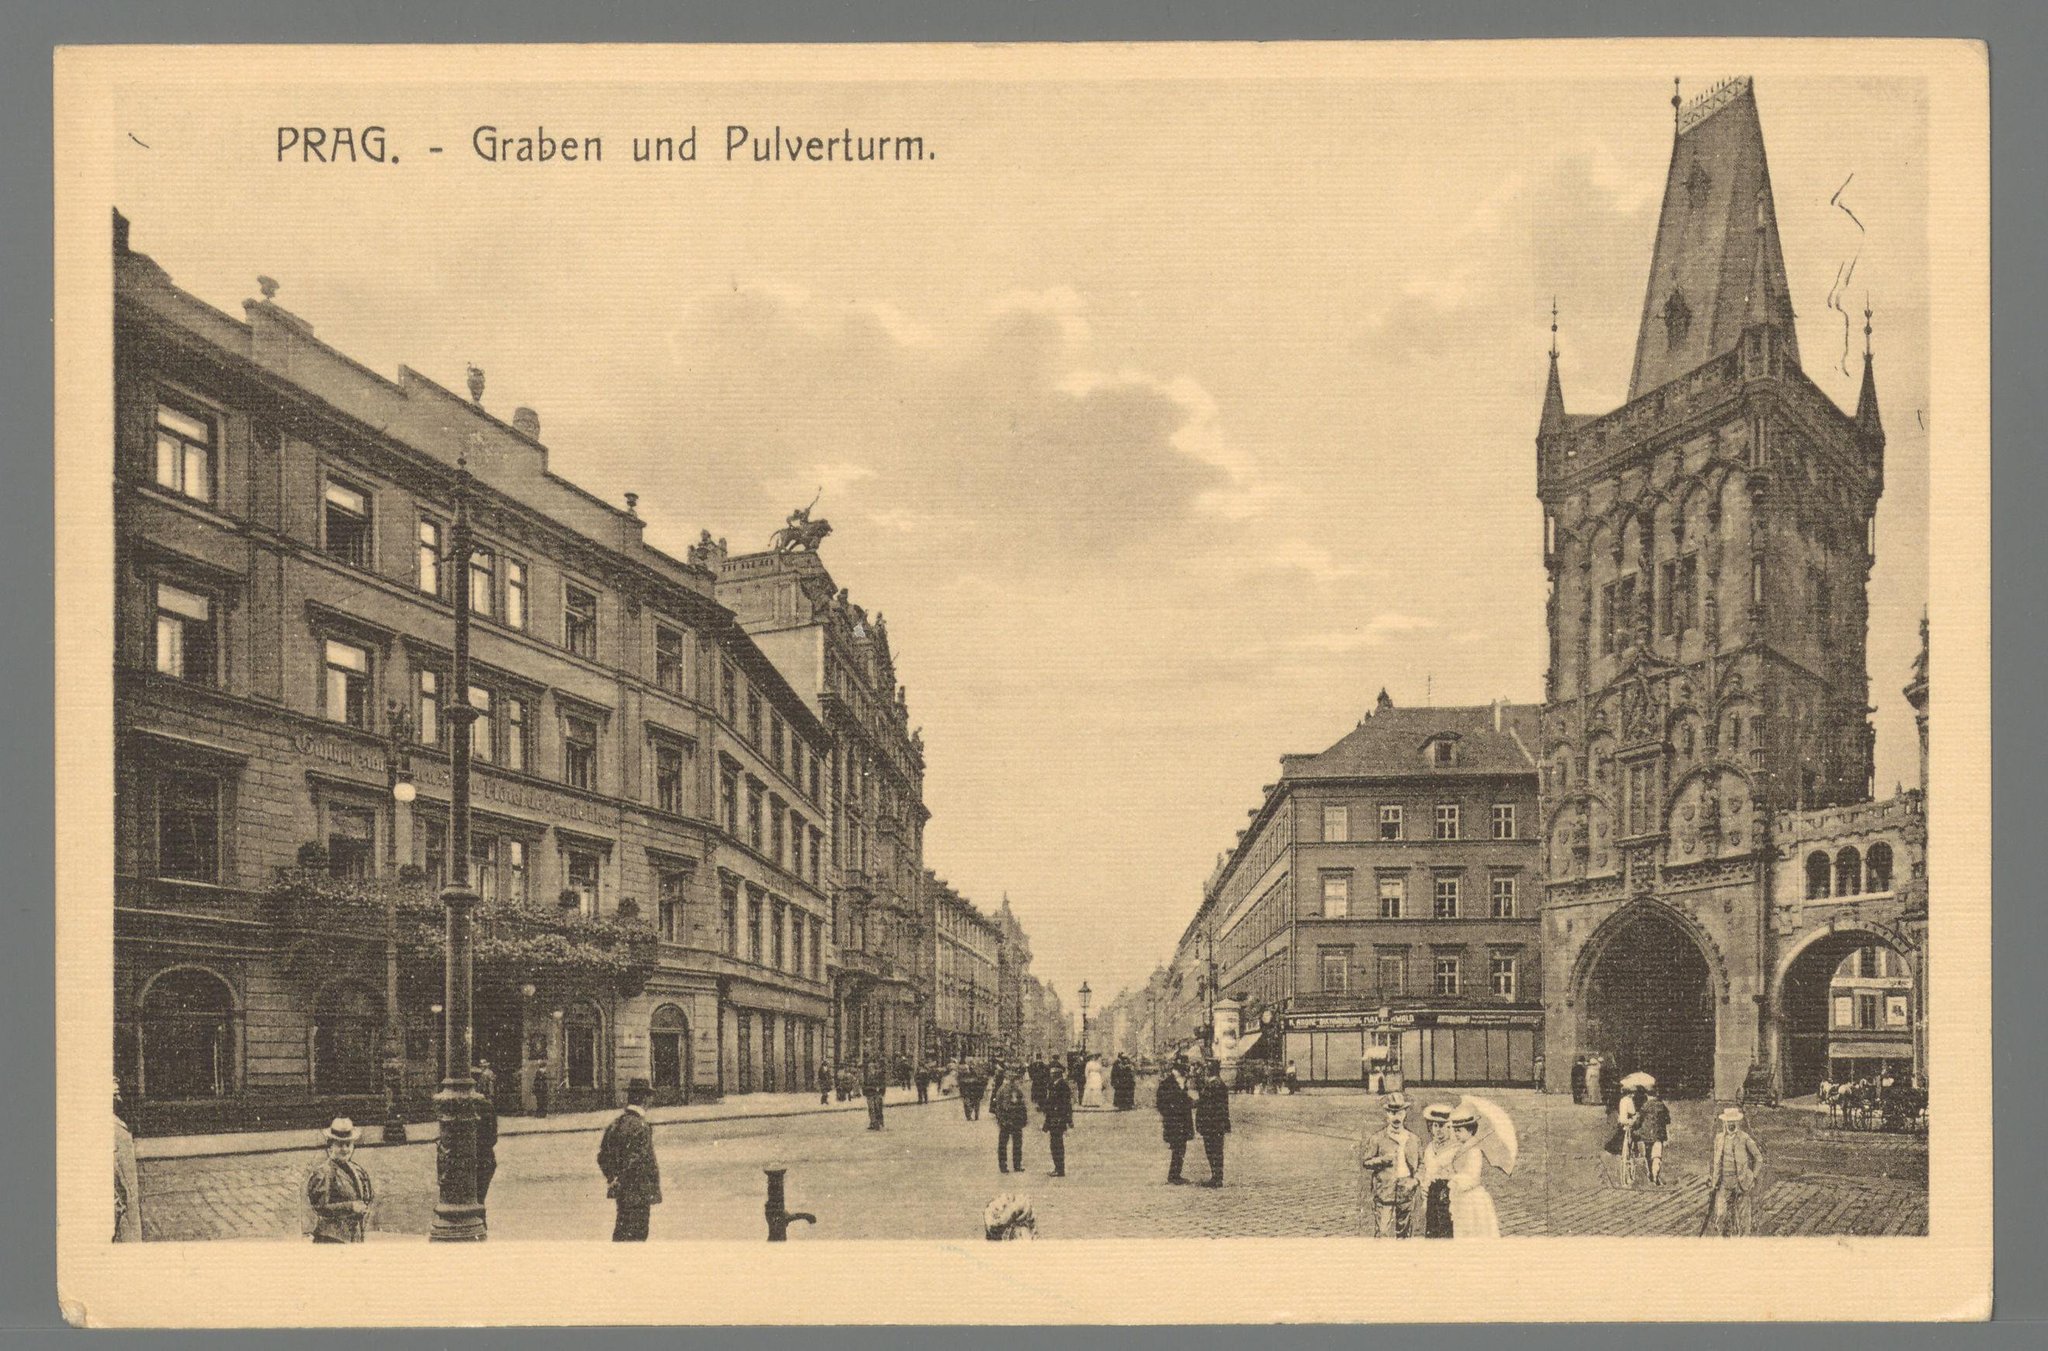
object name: photomechanical print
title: Prag - Graben und Pulverturm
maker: Anonymous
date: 1906-1920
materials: cardboard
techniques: photograph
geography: prague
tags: square, place, circus, etc., street, city-gate